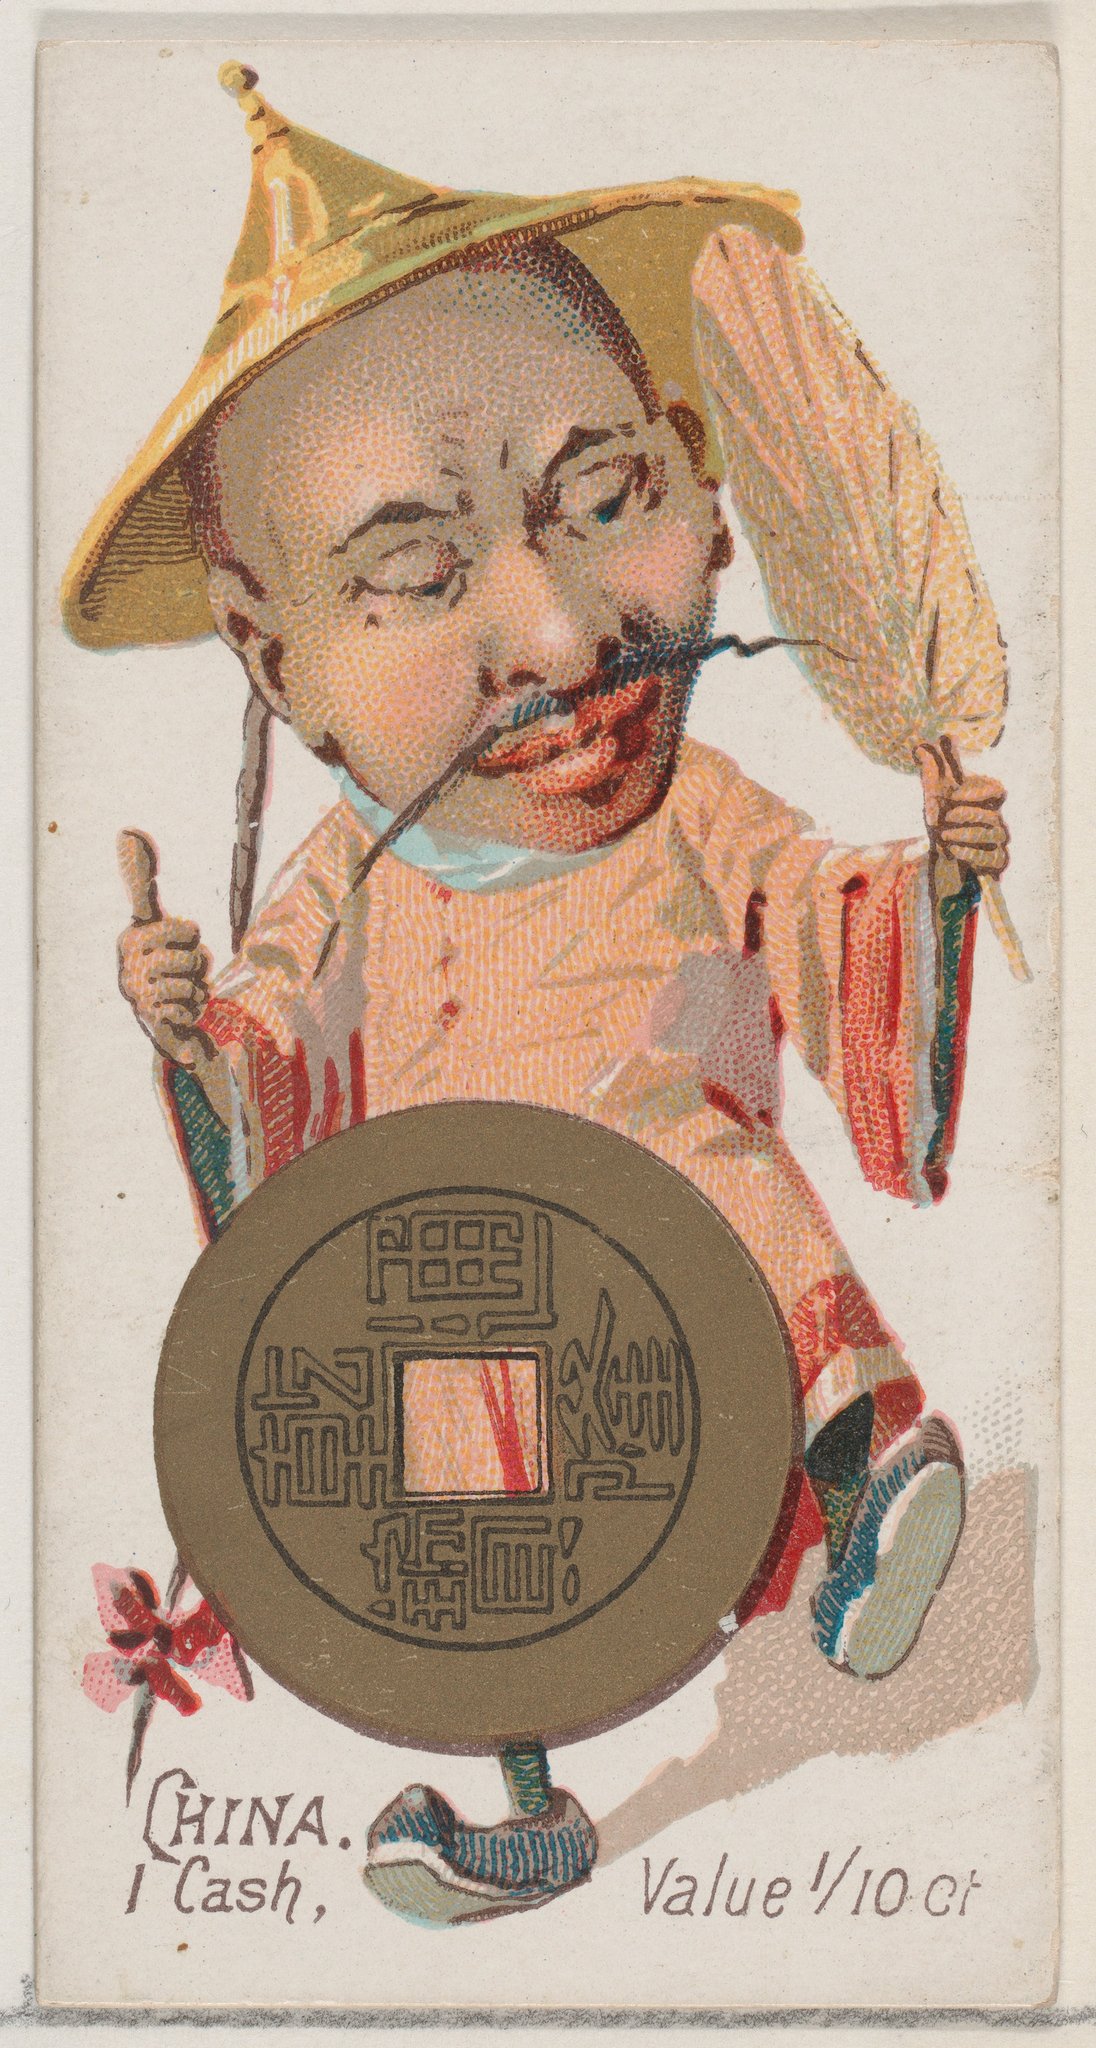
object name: print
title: Caricatured Chinese figure, 1 Cash, from the series Coins of All Nations (N72, variation 1) for Duke brand cigarettes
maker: w. duke, sons & co.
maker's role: publisher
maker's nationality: american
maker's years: 1870-1920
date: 1889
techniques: color lithograph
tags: men,coins